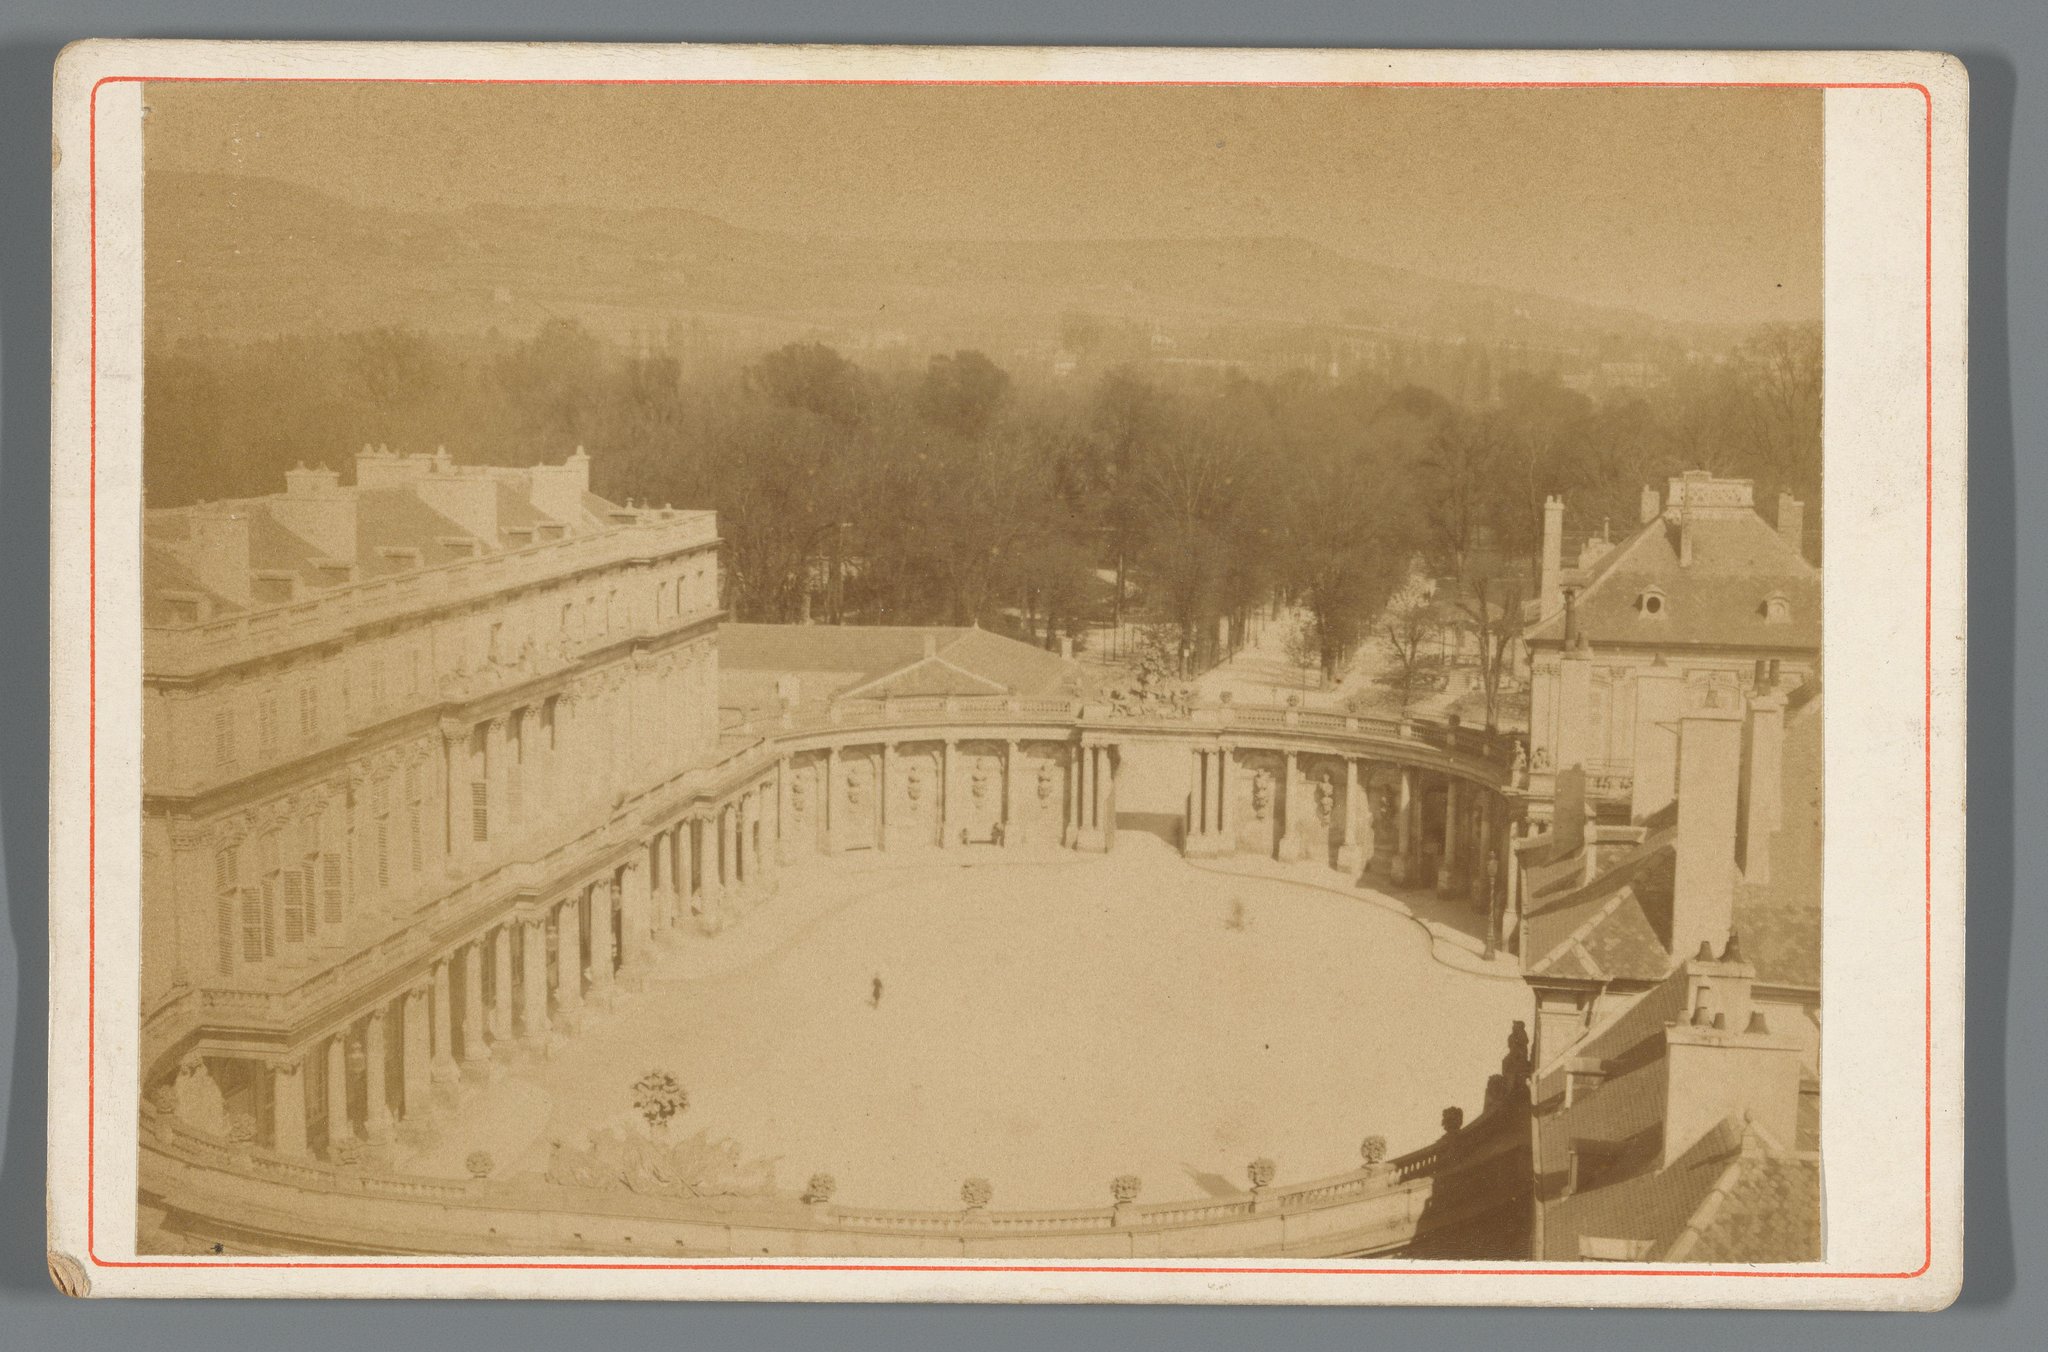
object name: cabinet photograph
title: Nancy - Palais du Gouvernement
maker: Anonymous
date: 1866-1910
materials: cardboard, paper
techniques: albumen print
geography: nancy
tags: square, place, circus, etc., palace